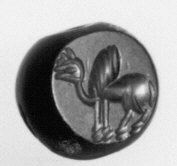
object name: stamp seal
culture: sasanian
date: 201-700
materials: jasper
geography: iran or mesopotamia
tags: animals